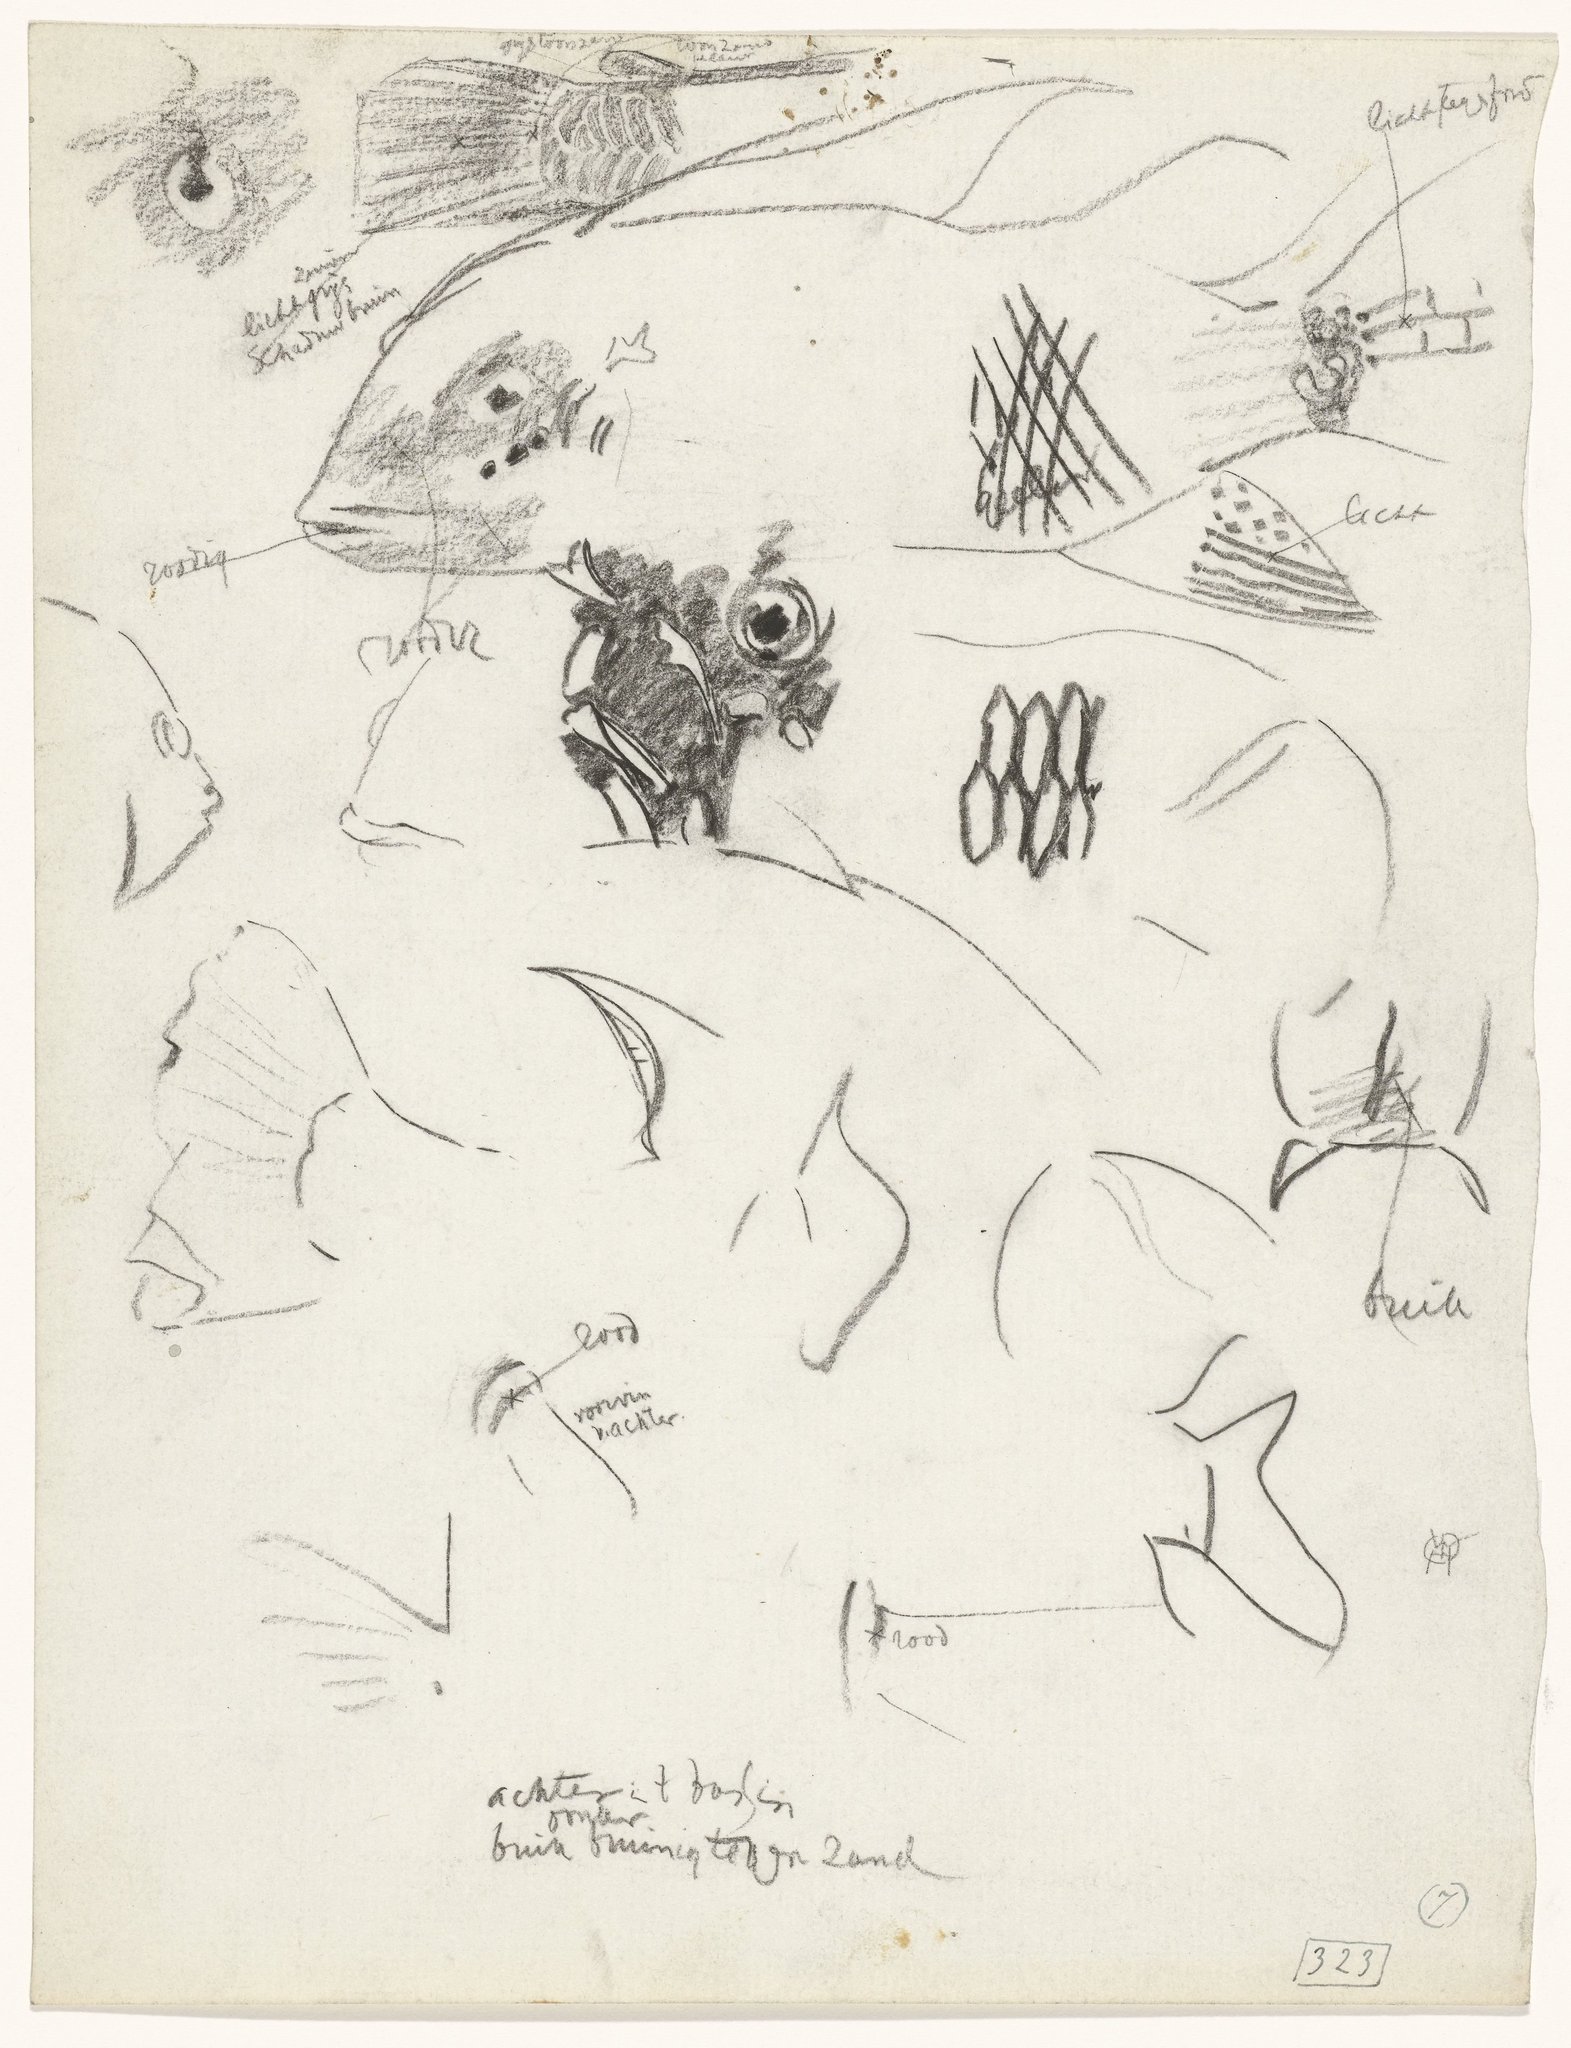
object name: drawing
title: Detailstudies van vissen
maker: gerrit willem dijsselhof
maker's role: designer, draughtsman, print maker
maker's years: 1866-1924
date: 1876-1924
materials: chalk, paper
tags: fishes